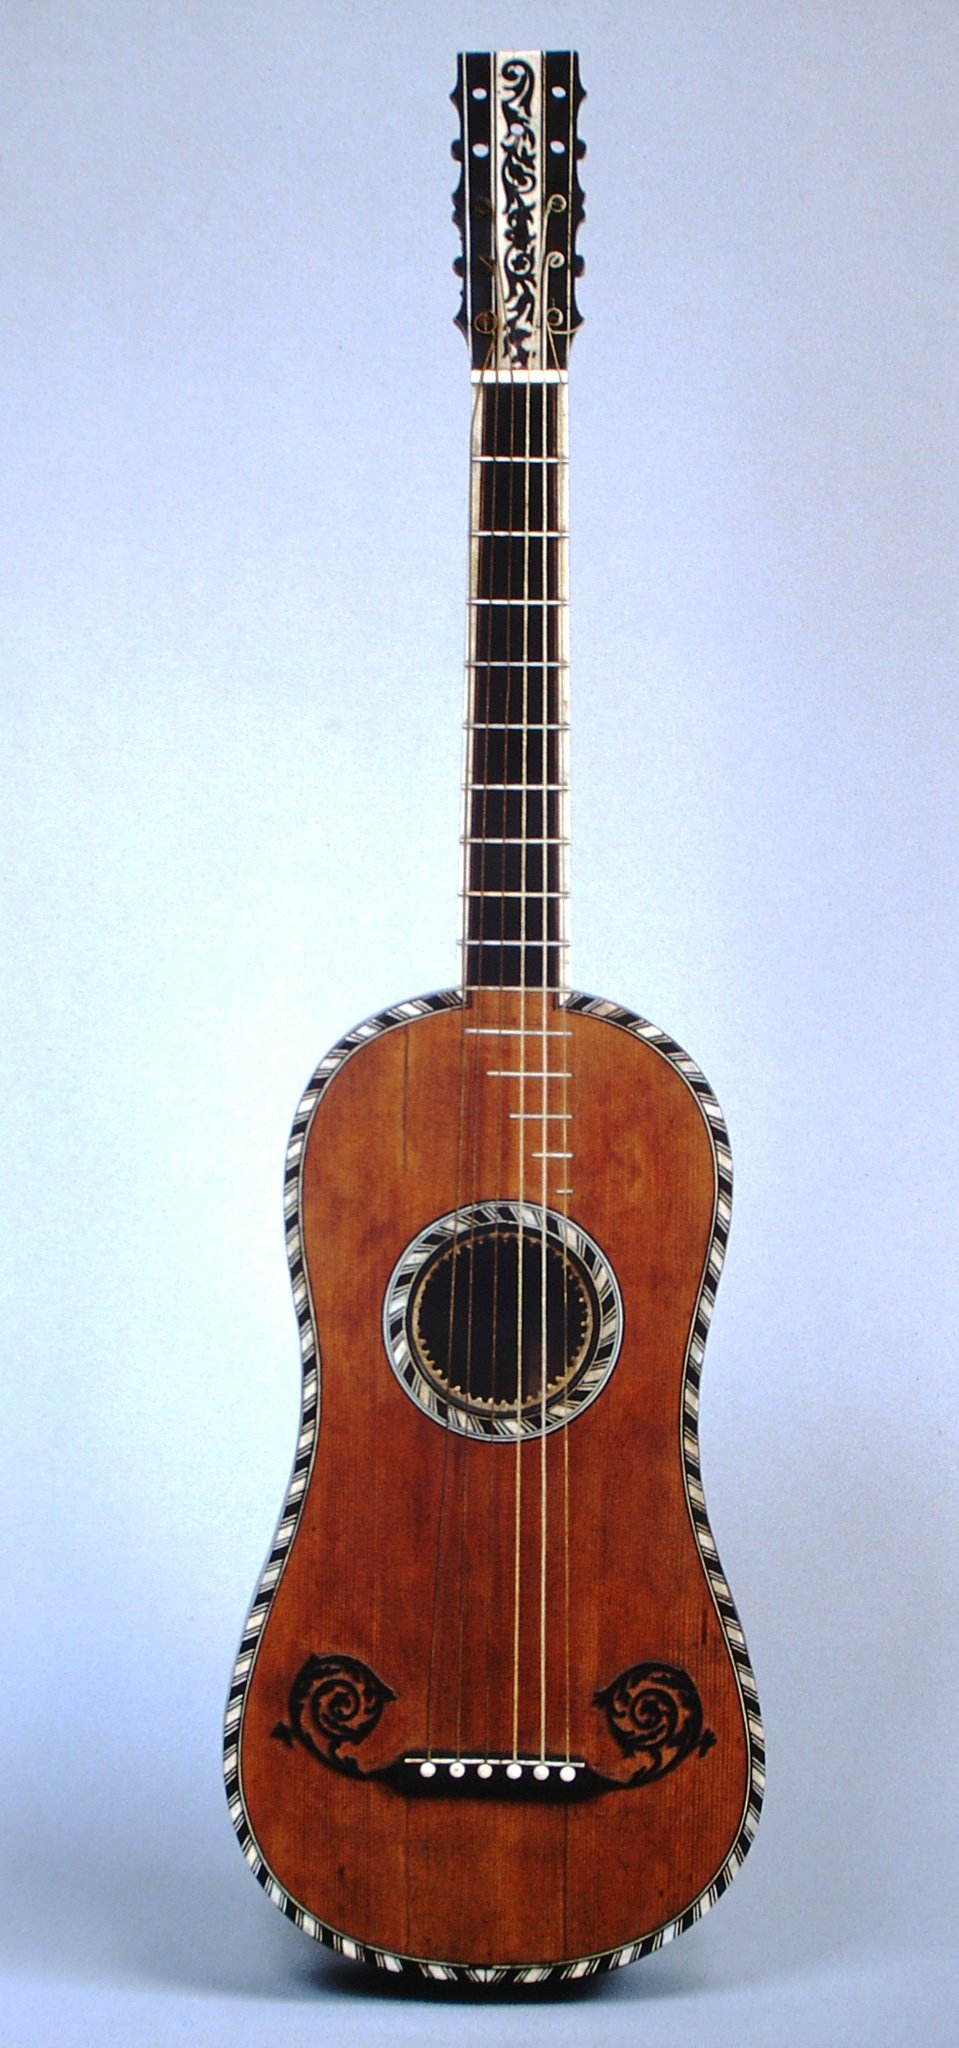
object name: guitar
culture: french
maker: robert chéron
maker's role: artist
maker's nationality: french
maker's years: 1600-1700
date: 1694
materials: wood, ivory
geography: france